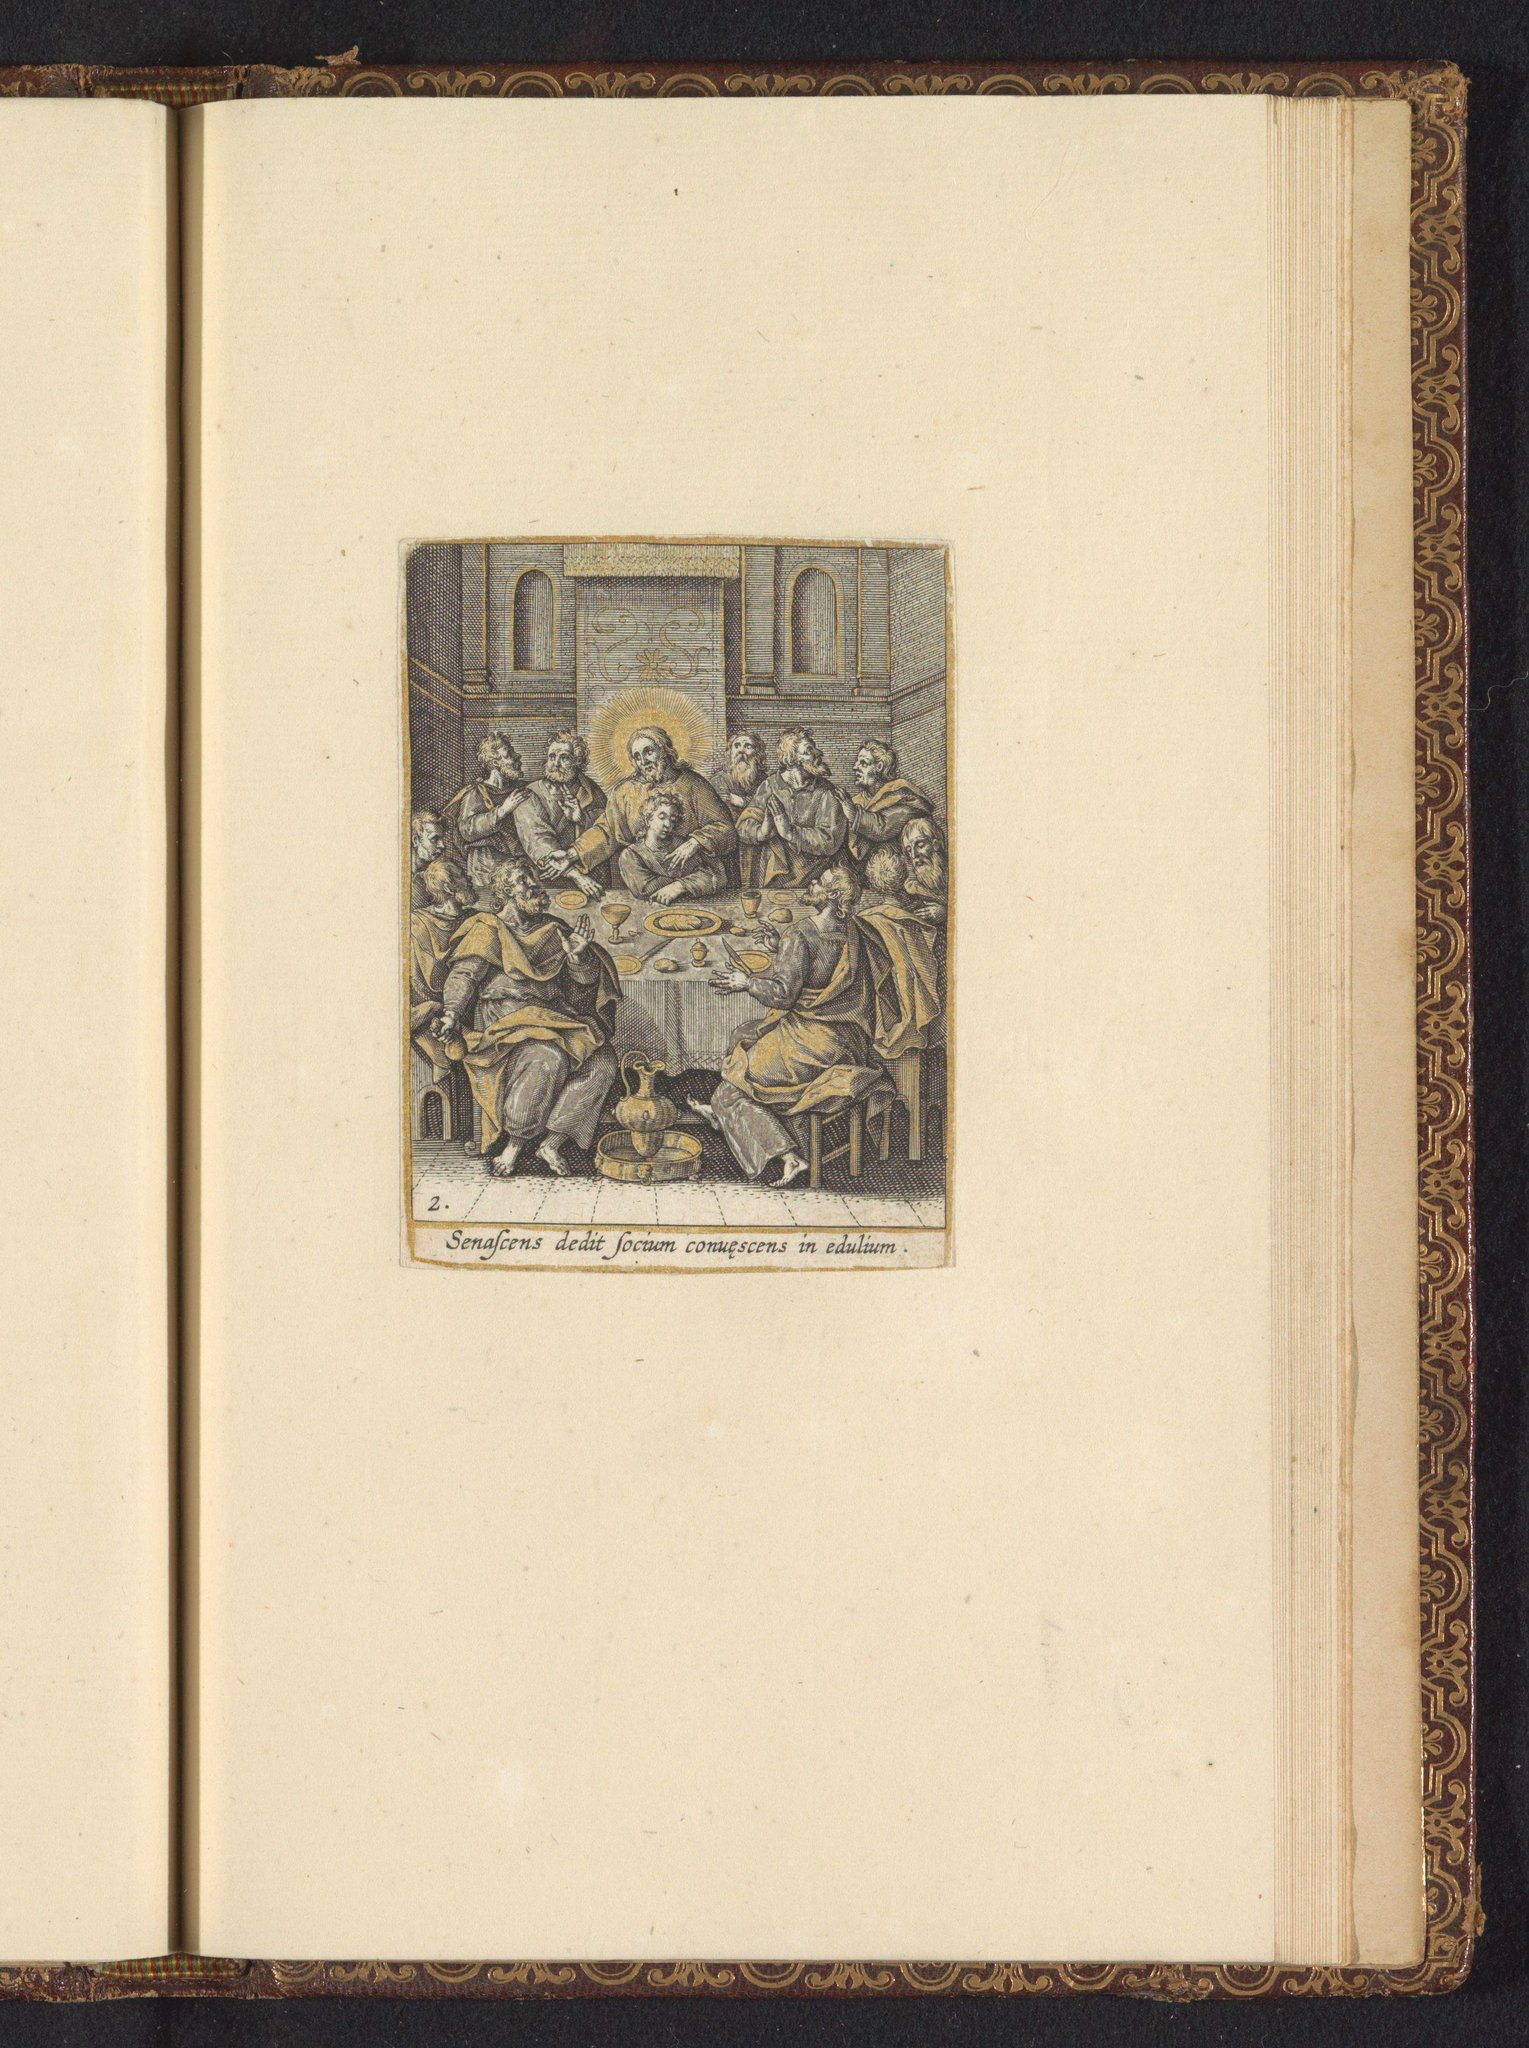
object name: print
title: Laatste Avondmaal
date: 1580-1590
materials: gold, paper, silver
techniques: engraving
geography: antwerp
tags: last supper (in general) (matthew 26:21-35; mark 14:18-31; luke 22:3, 22:15-23; john 13:21-38)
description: Laatste Avondmaal. Onderdeel van de prentserie over de passie van Christus: Passio et resurrectio D.N. Iesu Christi. Edita et excusa ab Ad. Collaert. In prentalbum met twee reeksen van respectievelijk 34 en 24 gravures met scènes uit het leven en het lijdensverhaal van Christus.